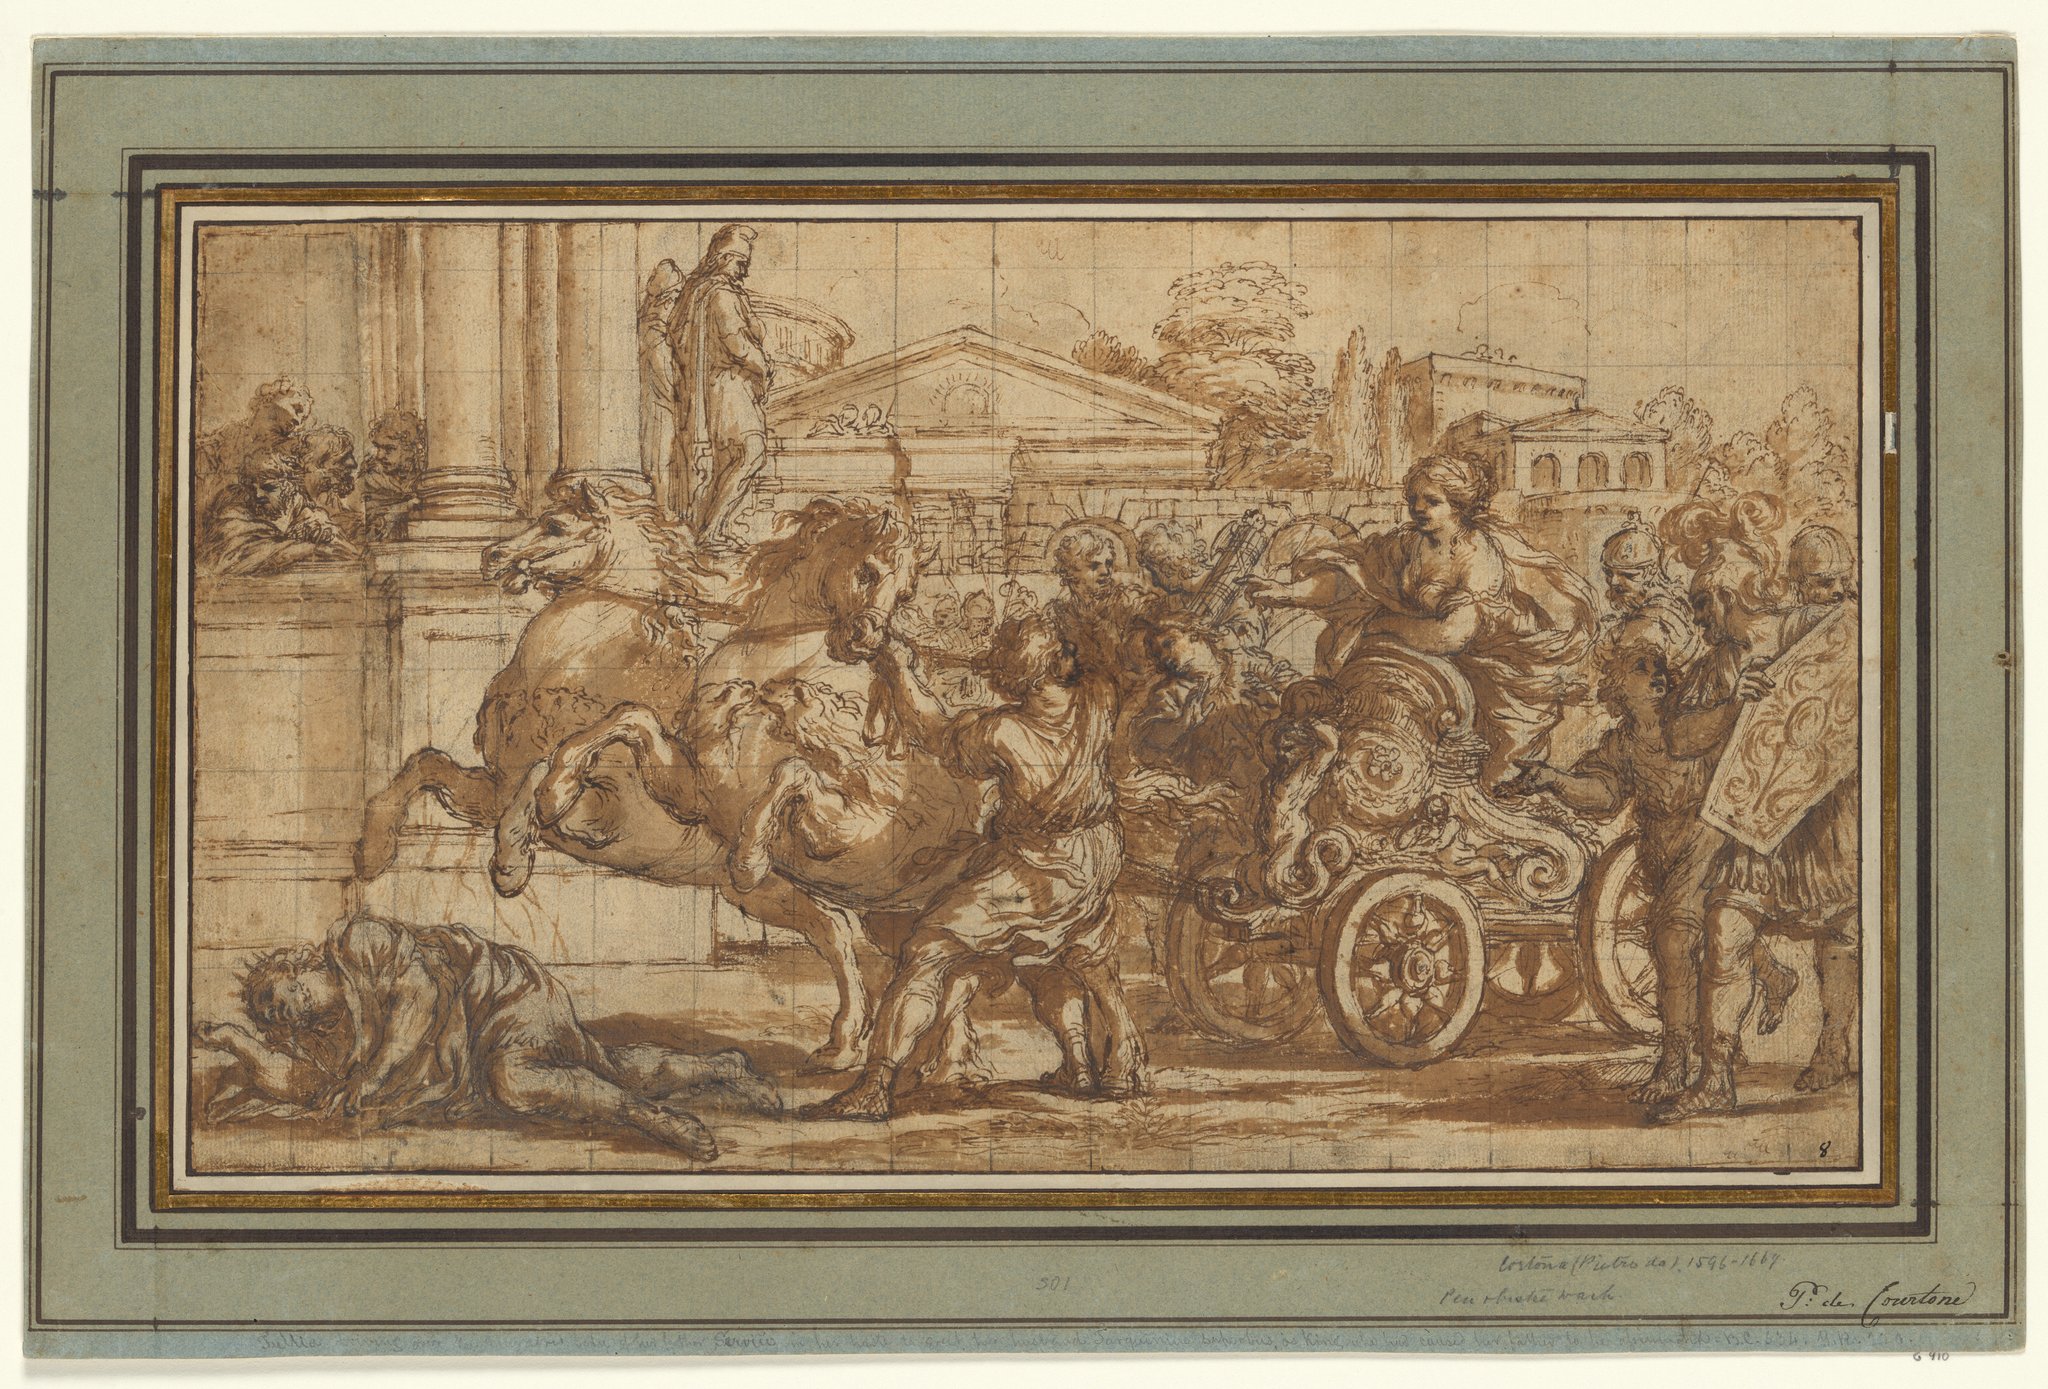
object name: drawing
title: Tullia Driving Her Chariot over the Body of Her Father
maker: ciro ferri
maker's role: artist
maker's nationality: italian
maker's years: 1634-1689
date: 1655-1670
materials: chalk, ink, pencil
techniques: pen, drawing, wash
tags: soldiers,men,women,horses,chariots